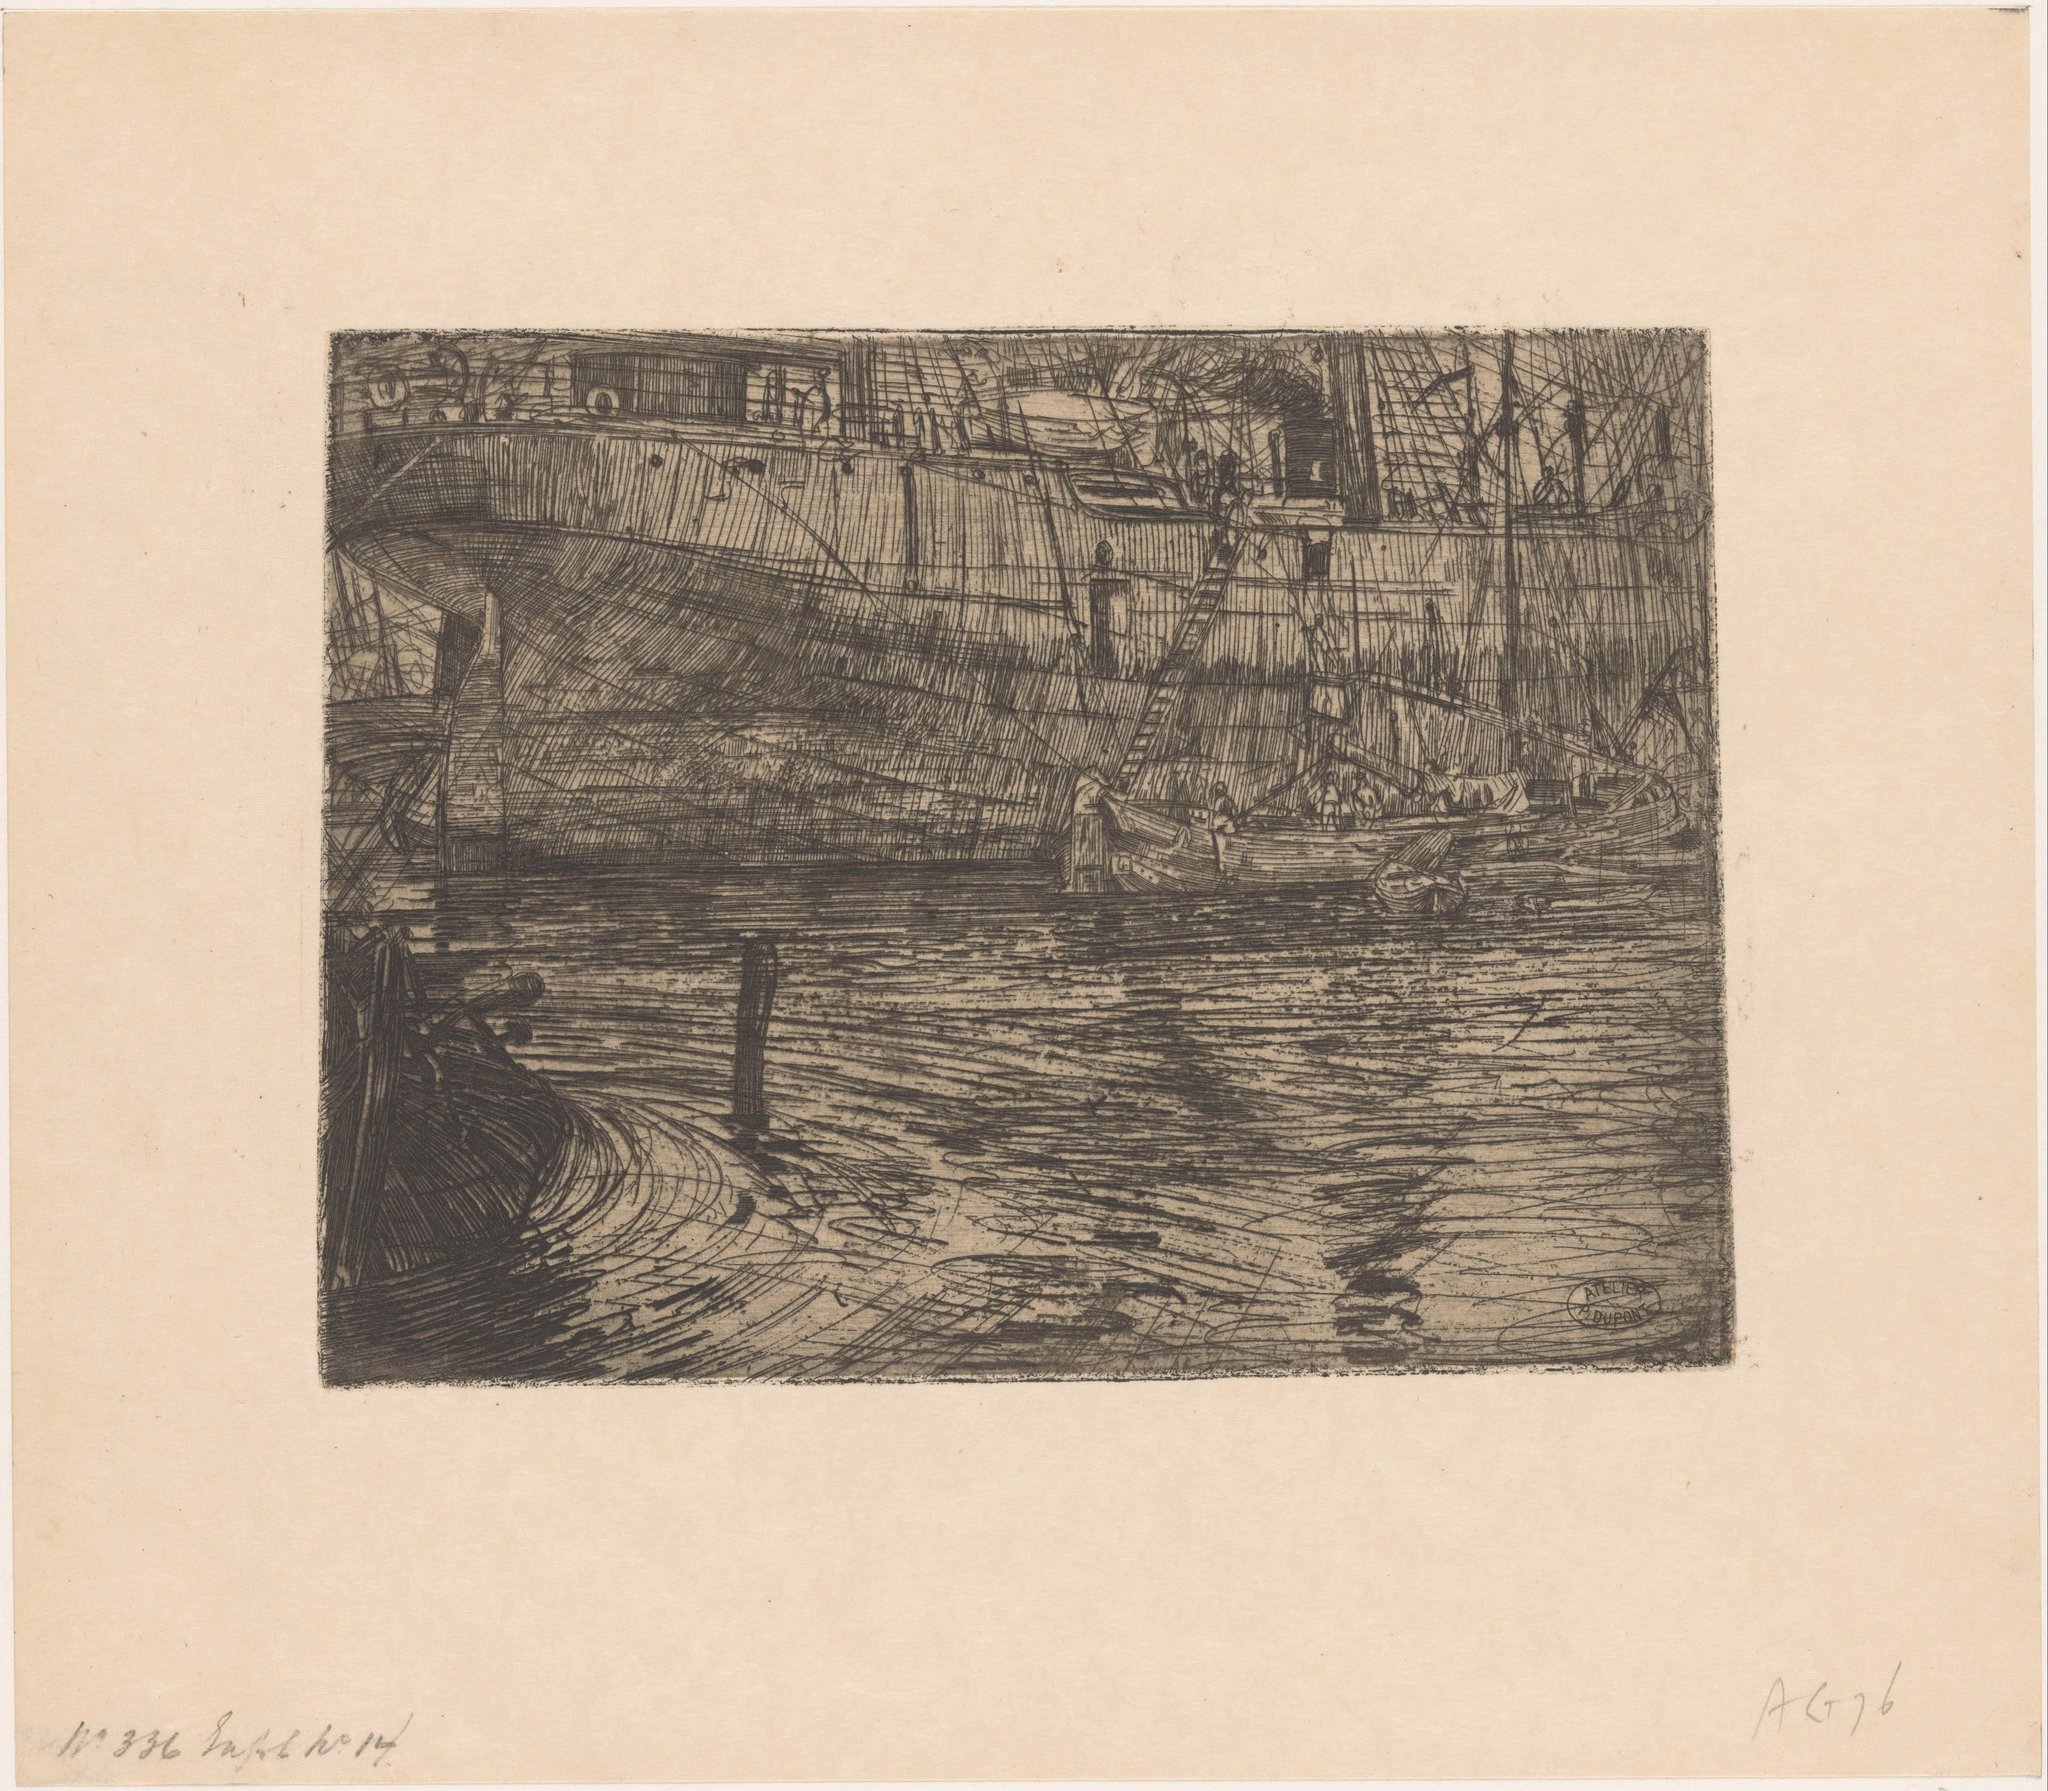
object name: print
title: Stoomboot in het Westerdok in Amsterdam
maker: pieter dupont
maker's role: draughtsman, print maker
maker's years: 1870-1911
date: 1895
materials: paper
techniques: intaglio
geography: amsterdam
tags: ships (in general)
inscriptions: collector's mark: Lugt 2228, workshop stamp: ‘ATELIER P. DUPONT’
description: Het achterschip van een vrachtboot. Een tjalk ligt langszij afgemeerd.